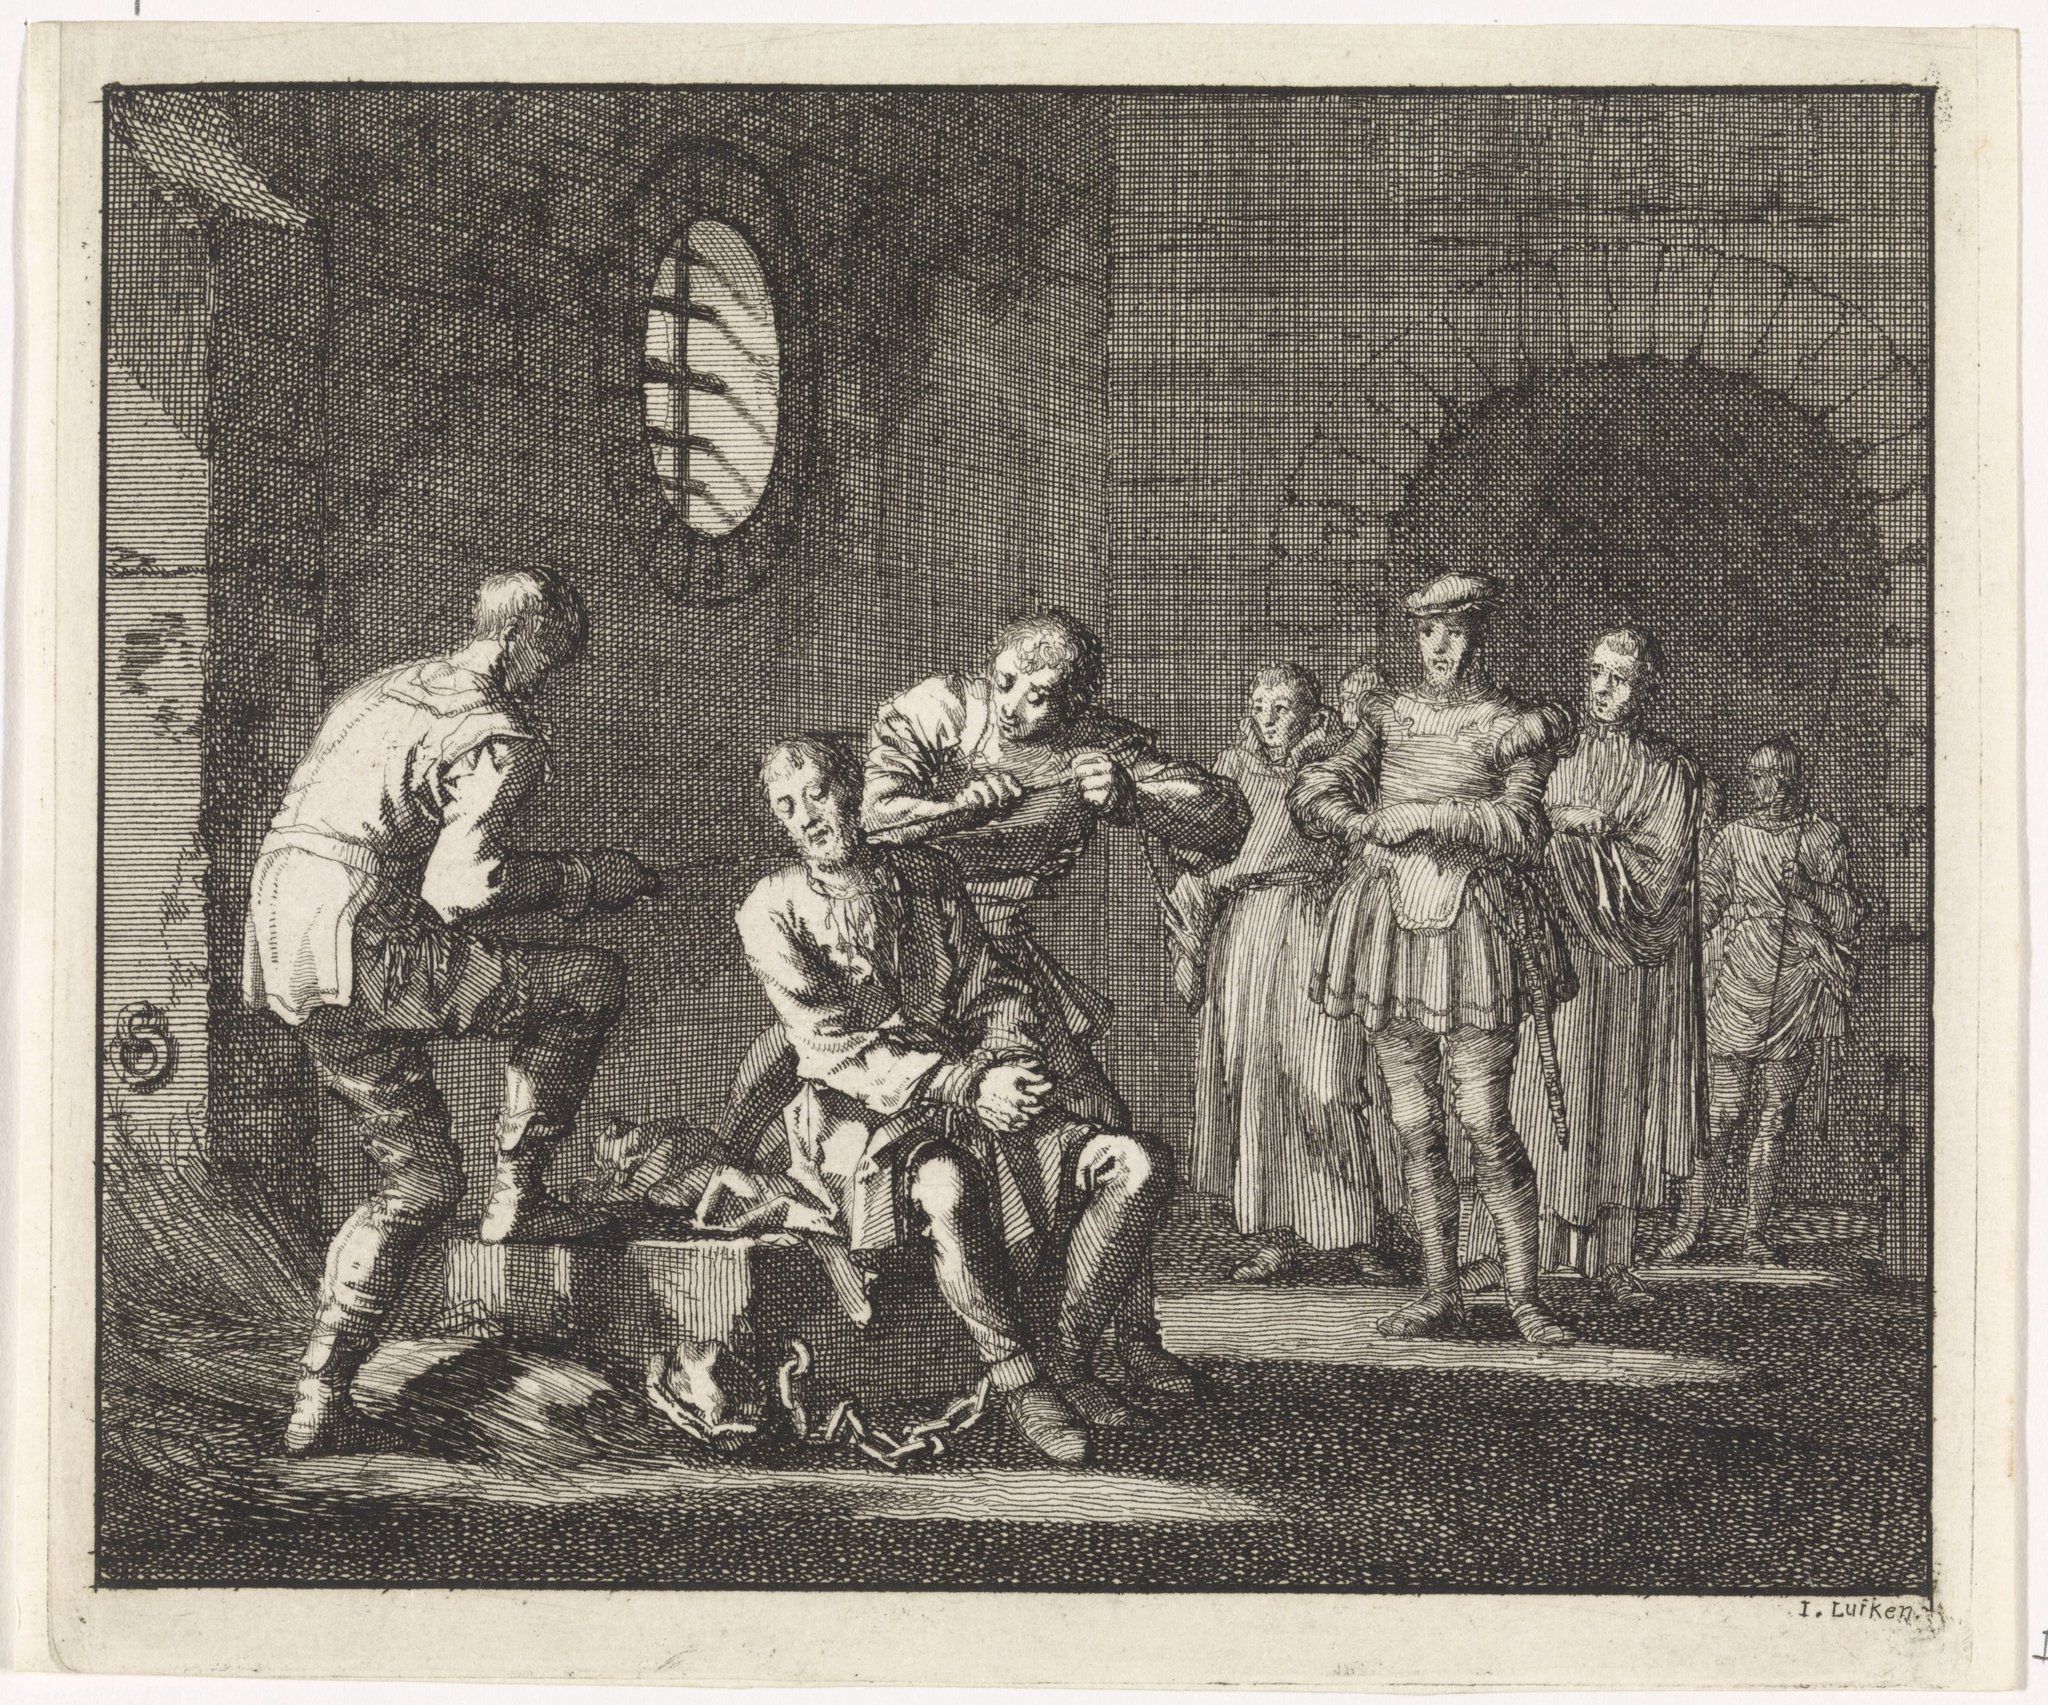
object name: print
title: Arnulfus wordt in een gevangenis gewurgd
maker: jan luyken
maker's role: draughtsman, print maker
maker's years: 1649-1712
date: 1701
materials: paper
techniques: etching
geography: amsterdam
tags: prison, jail, the early christian churches, e.g. armenians, copts, syrians, monk(s), friar(s), violent death by strangling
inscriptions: collector's mark: Lugt 2228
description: Proefdruk van een boekillustratie Arnold, Godfried. Waare afbeelding der eerste christenen. Amsterdam: Jacobus van Hardenberg, Barent Visscher en Jacobus van Nieuweveen, 1700, dl. 2.